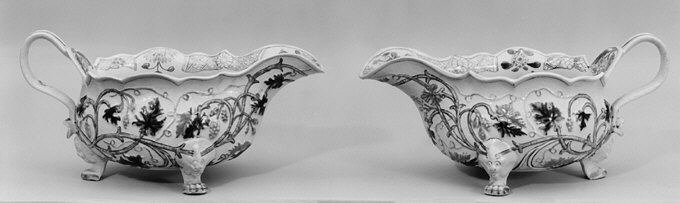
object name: sauceboat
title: Pair of sauceboats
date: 1750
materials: stoneware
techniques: salt glaze